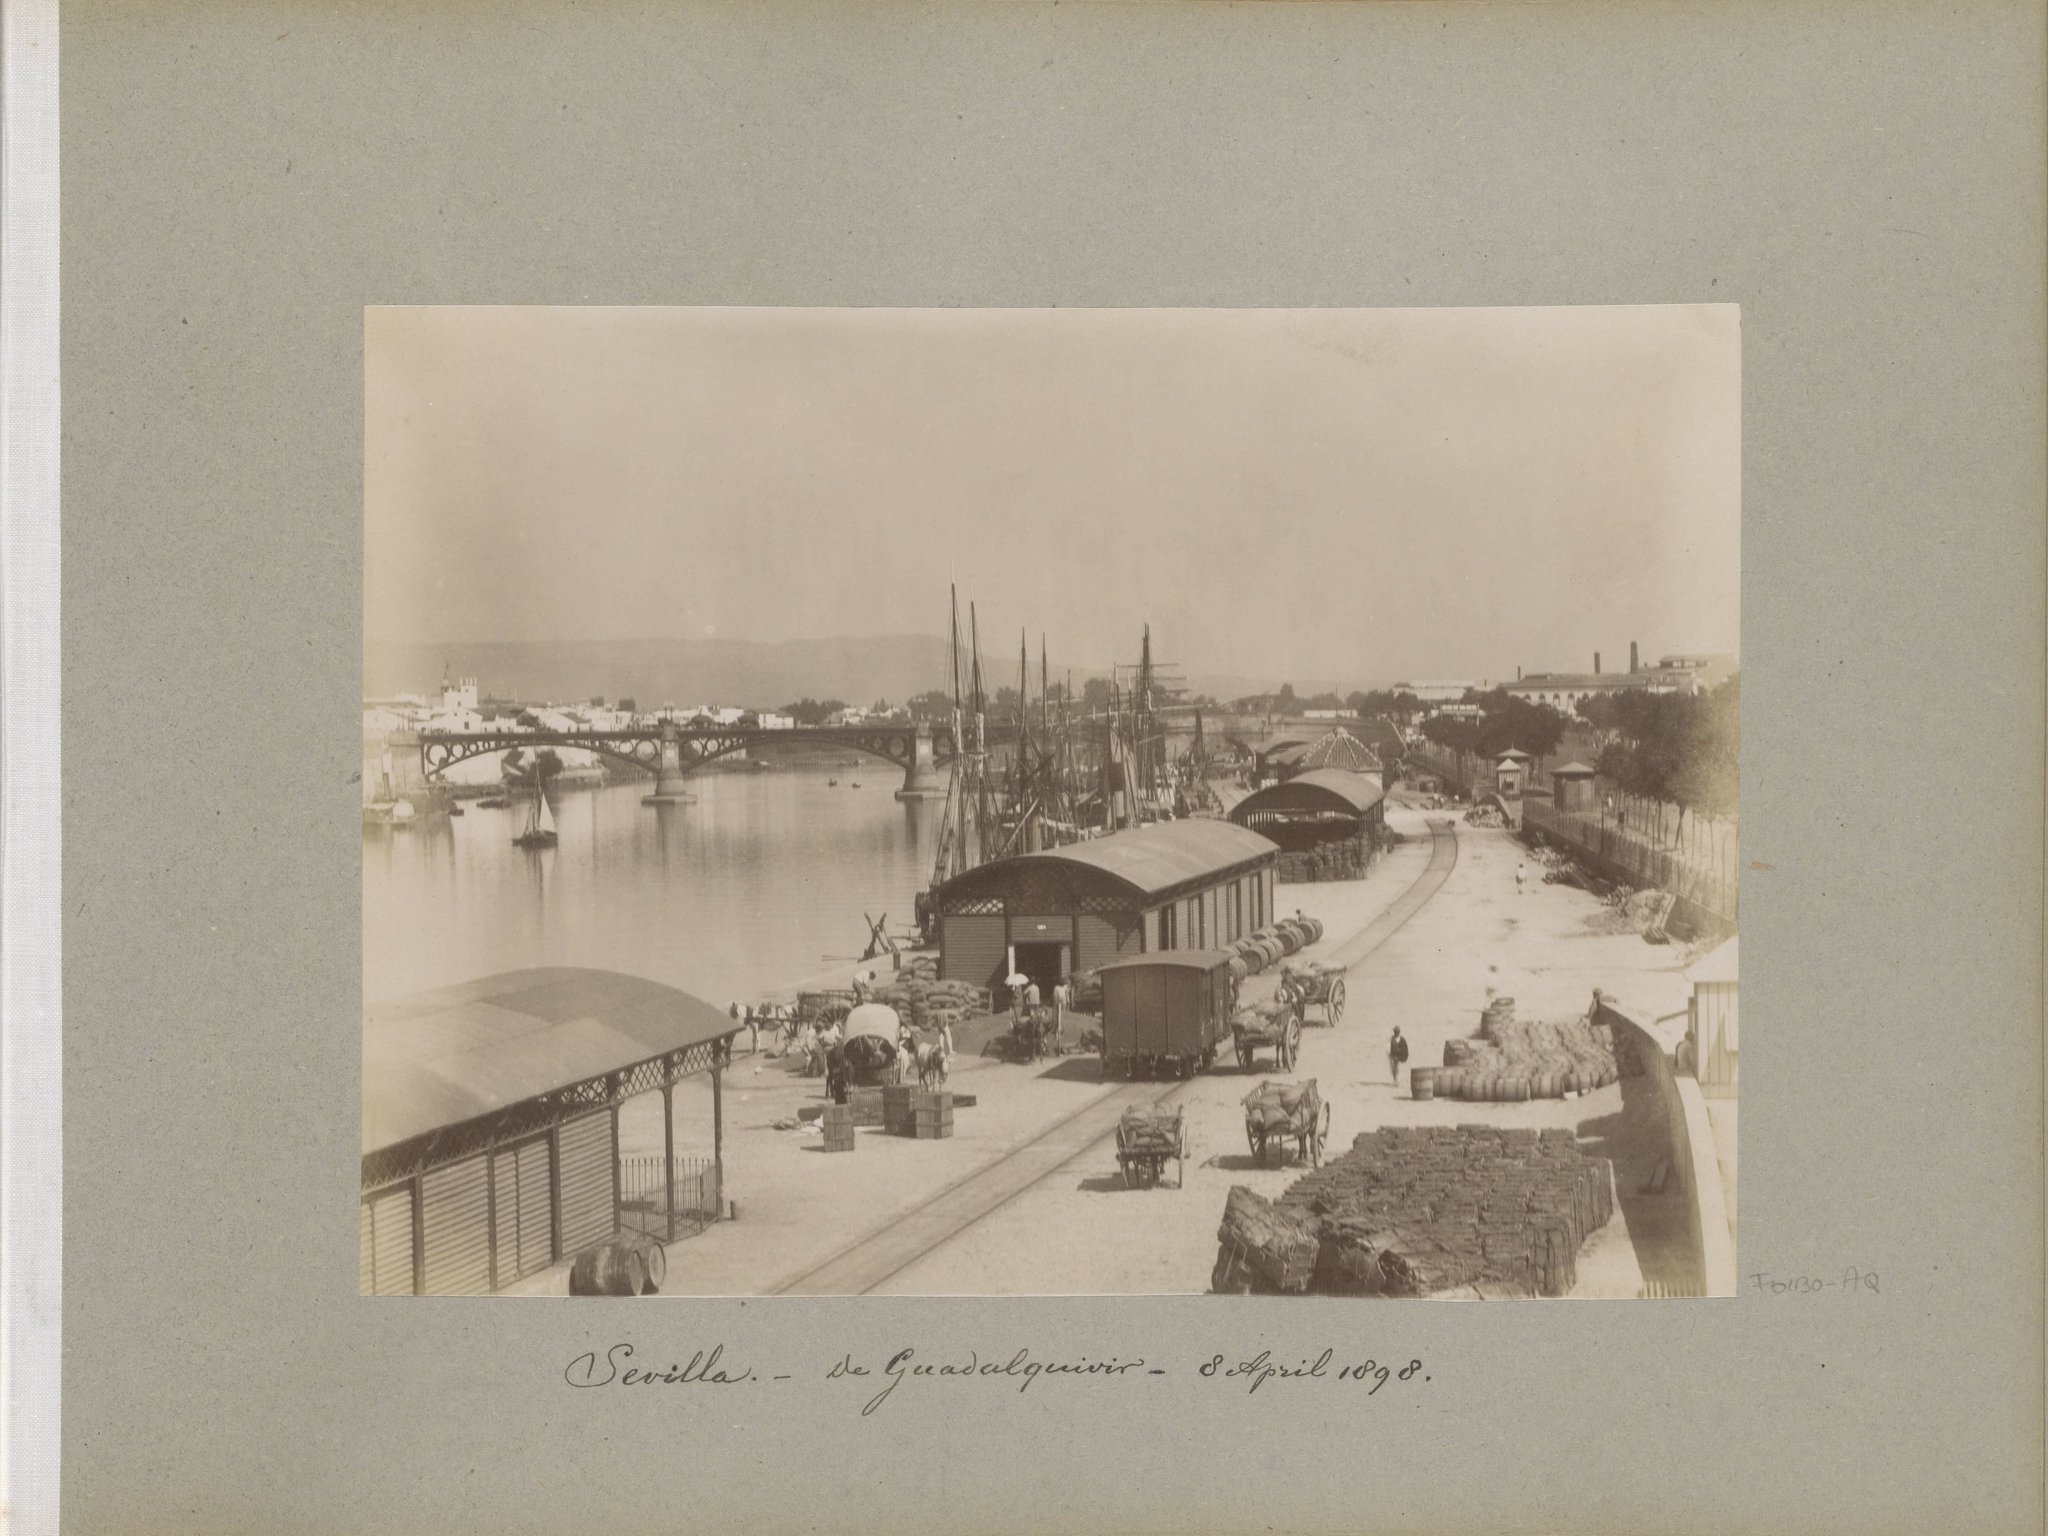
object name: photograph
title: Havengezicht bij de Guadalquivir in Sevilla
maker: emilio beauchy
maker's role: fotograaf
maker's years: 1847-1928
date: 1890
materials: paper, photographic support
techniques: albumen print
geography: sevilla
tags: harbour (+ view ~ vehicle, ship, etc.), sevilla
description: Onderdeel van Reisalbum met foto's van bezienswaardigheden in Frankrijk, Spanje, Italië, Duitsland, Zwitserland en Oostenrijk.